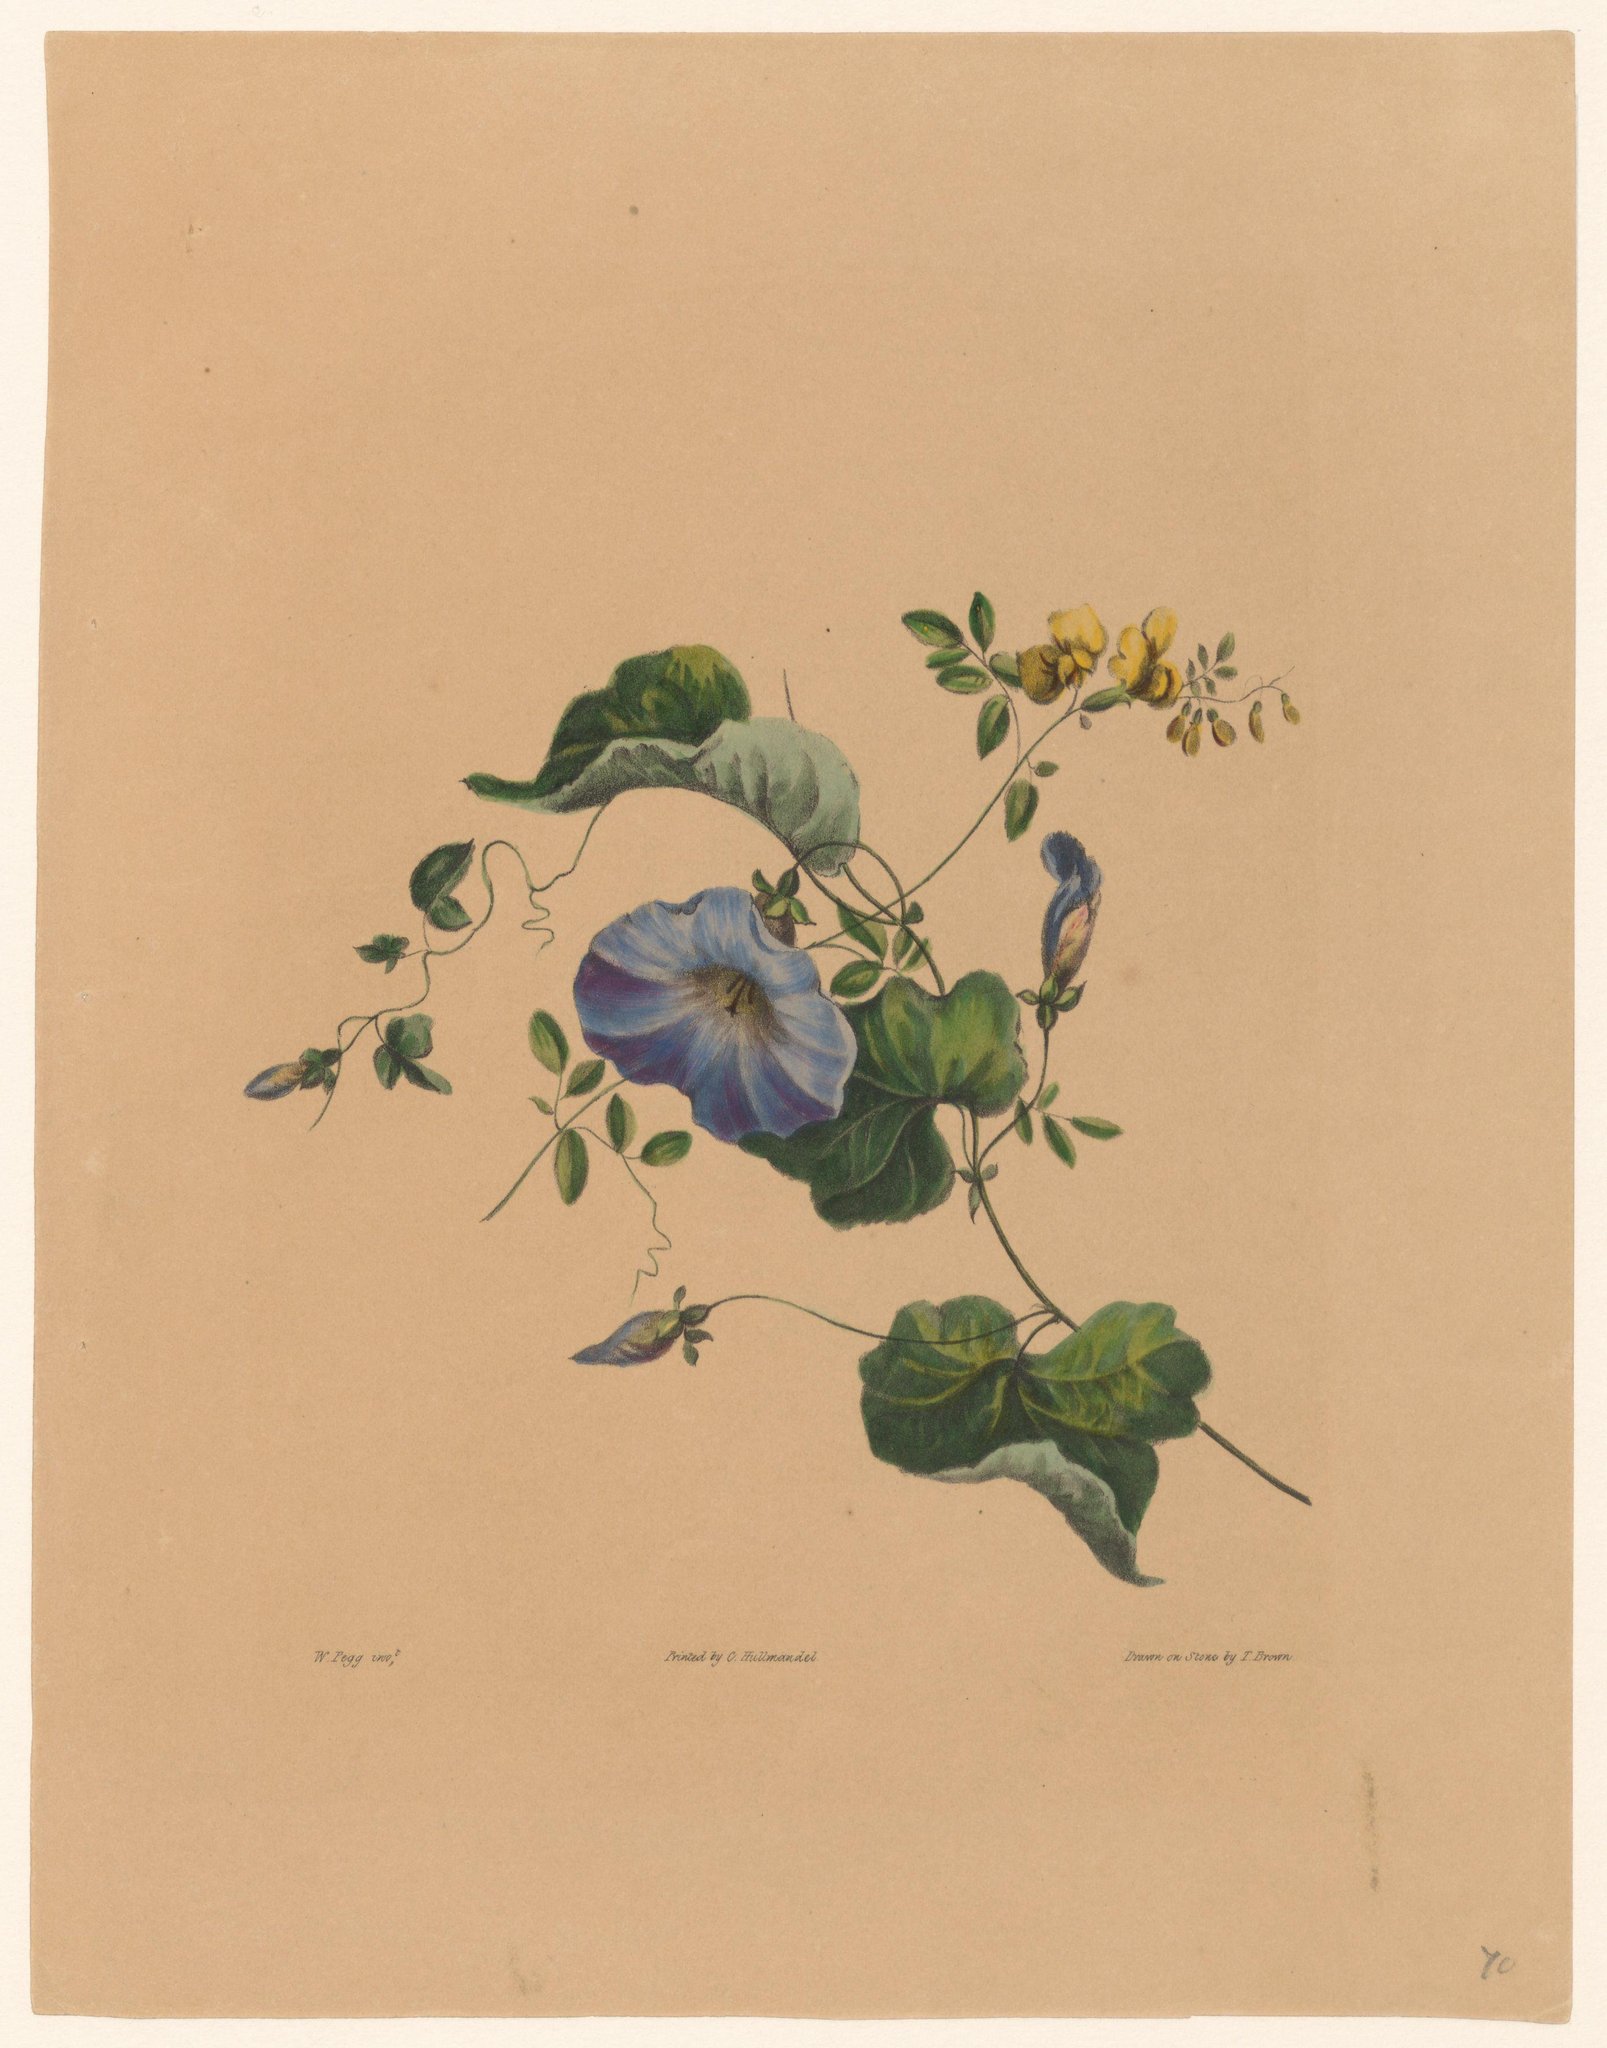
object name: print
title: Blauwe winde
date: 1820-1840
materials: paper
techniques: hand coloring, lithograph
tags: flowers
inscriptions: collector's mark: Lugt 2228